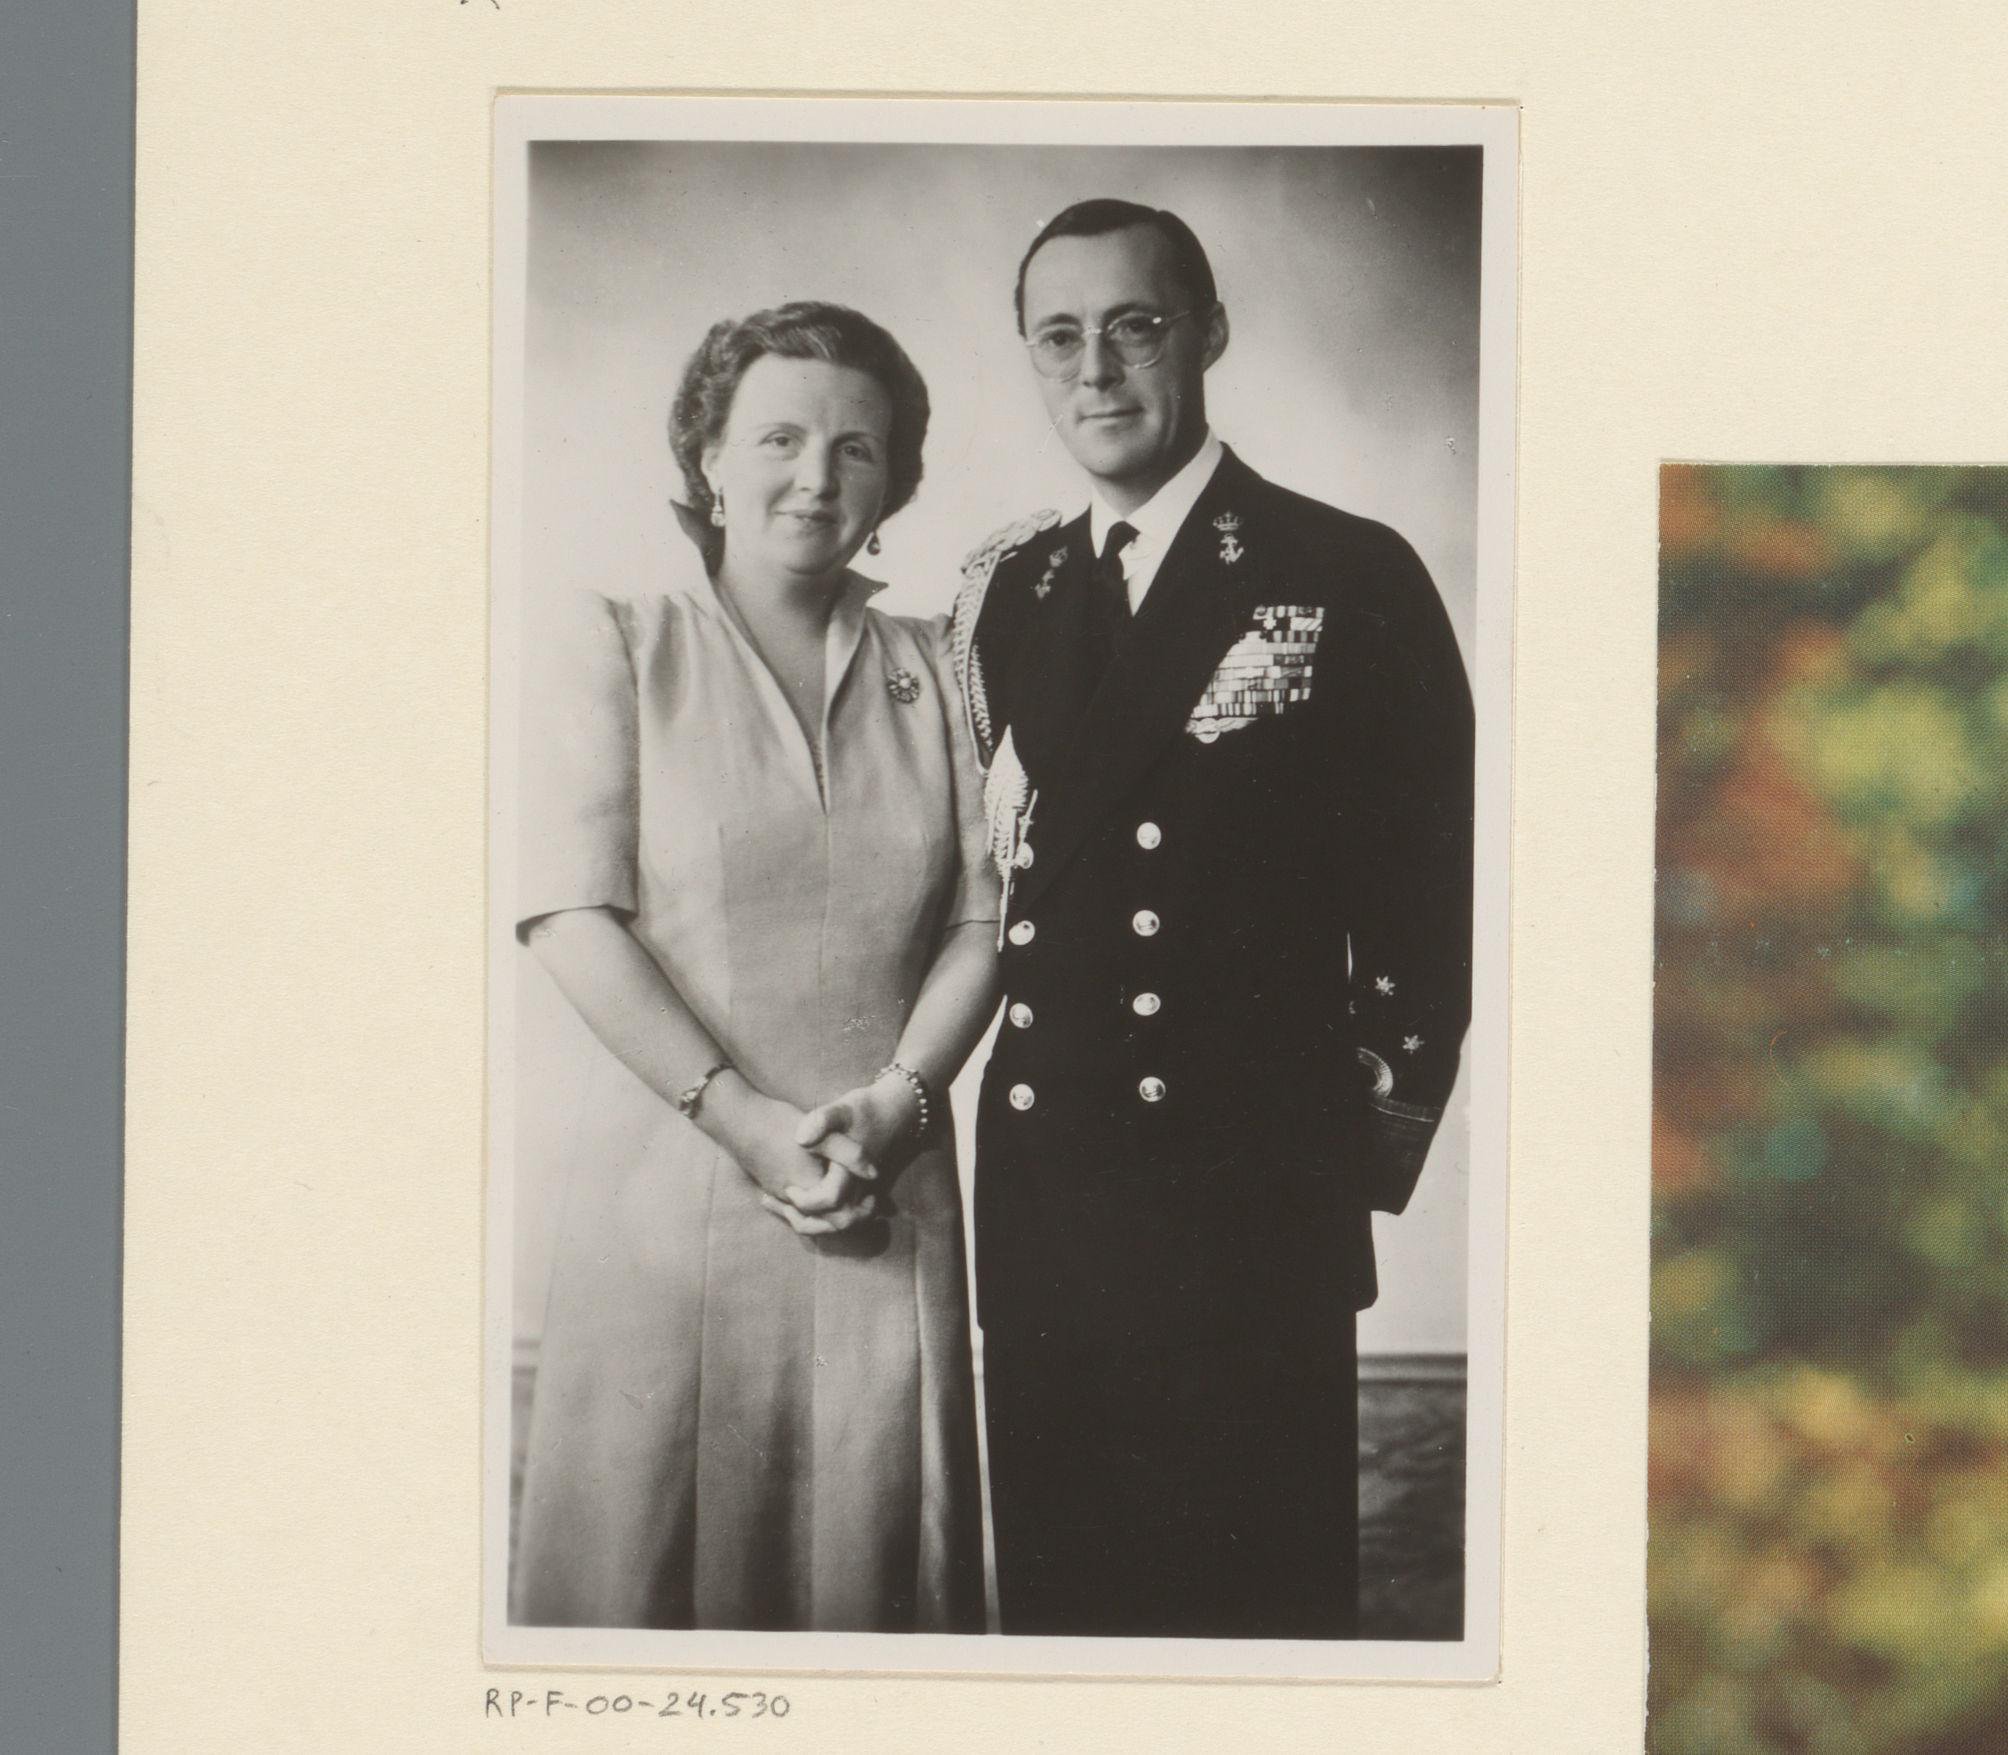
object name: ansichtkaart, prentbriefkaart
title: Koningin Juliana en prins Bernhard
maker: franz ziegler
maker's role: fotograaf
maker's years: 1893-1939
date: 1950-1951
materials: paper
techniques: gelatin silver print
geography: utrecht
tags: utrecht, bernhard (prins der nederlanden), the hague, juliana of the netherlands, historical persons - bb - woman, historical persons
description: Portret van koningin Juliana en prins Bernhard, ca. 1950-1951.